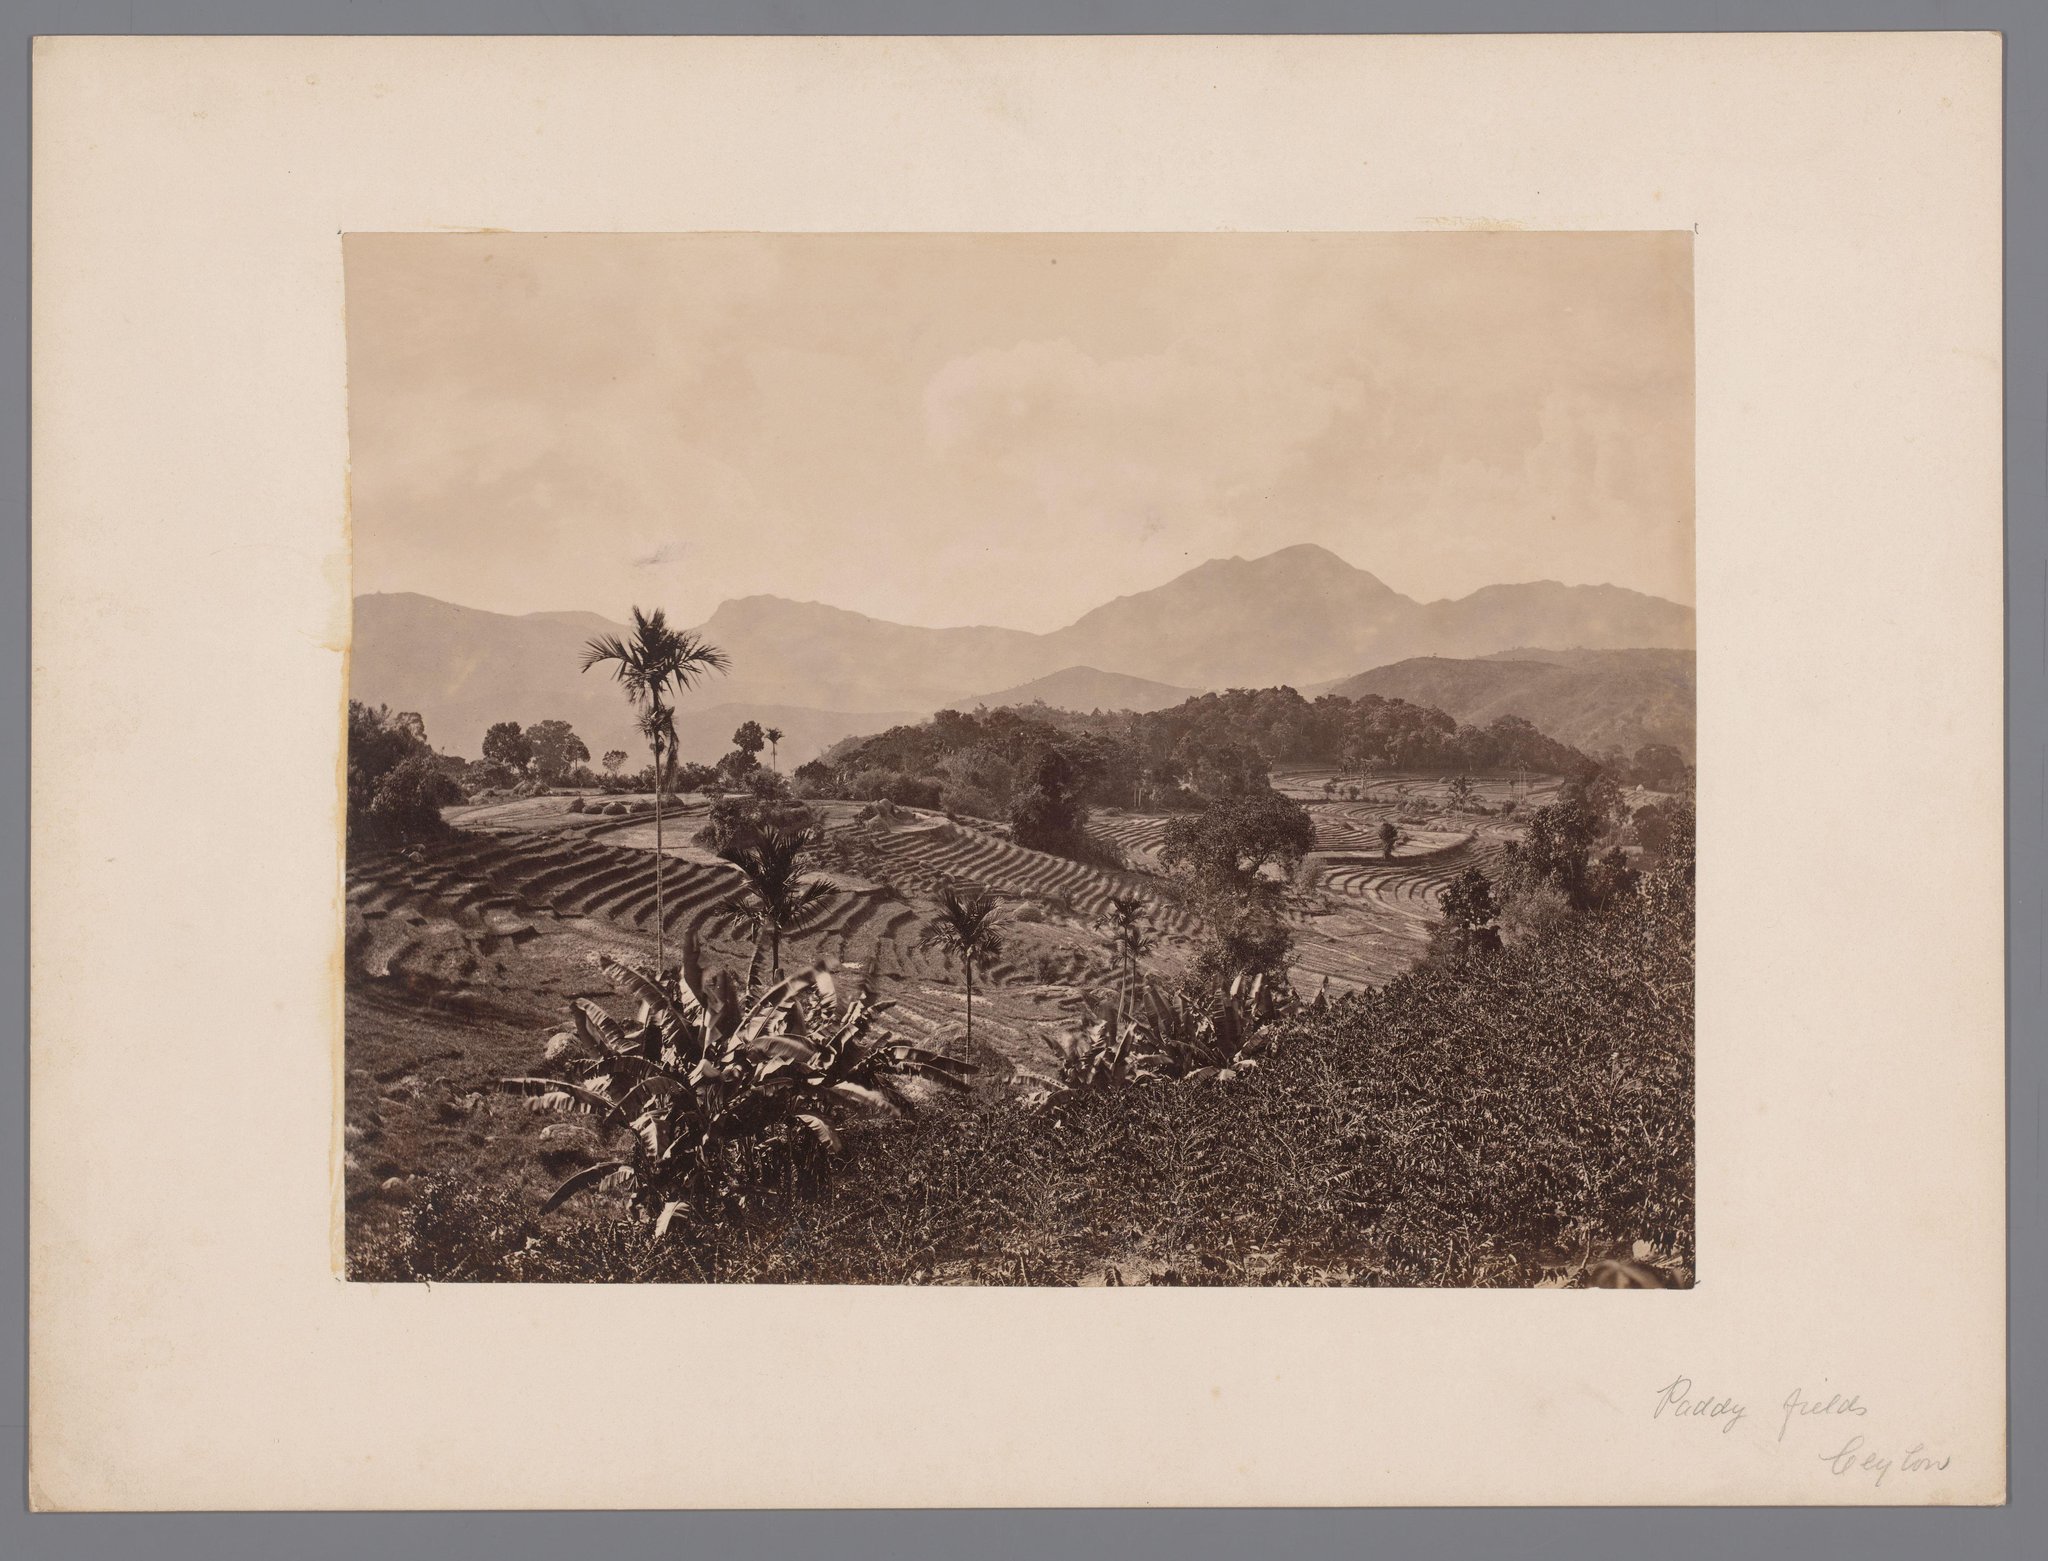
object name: photograph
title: Paddy Fields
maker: Anonymous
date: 1870-1890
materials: cardboard, paper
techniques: albumen print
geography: sri lanka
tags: sri lanka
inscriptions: number: ‘1183.’, date: ‘1860's’, caption: ‘ogliti di St. Zinone [?]’, stamp: ‘Fotografia E. Bressanini’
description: Uitzicht over omdijkt of ommuurd land, onderverdeeld door lage lemen walletjes voor het verbouwen van rijst. De velden worden hier, zoals in een heuvelachtig landschap gebruikelijk, in terrasvorm aangelegd.